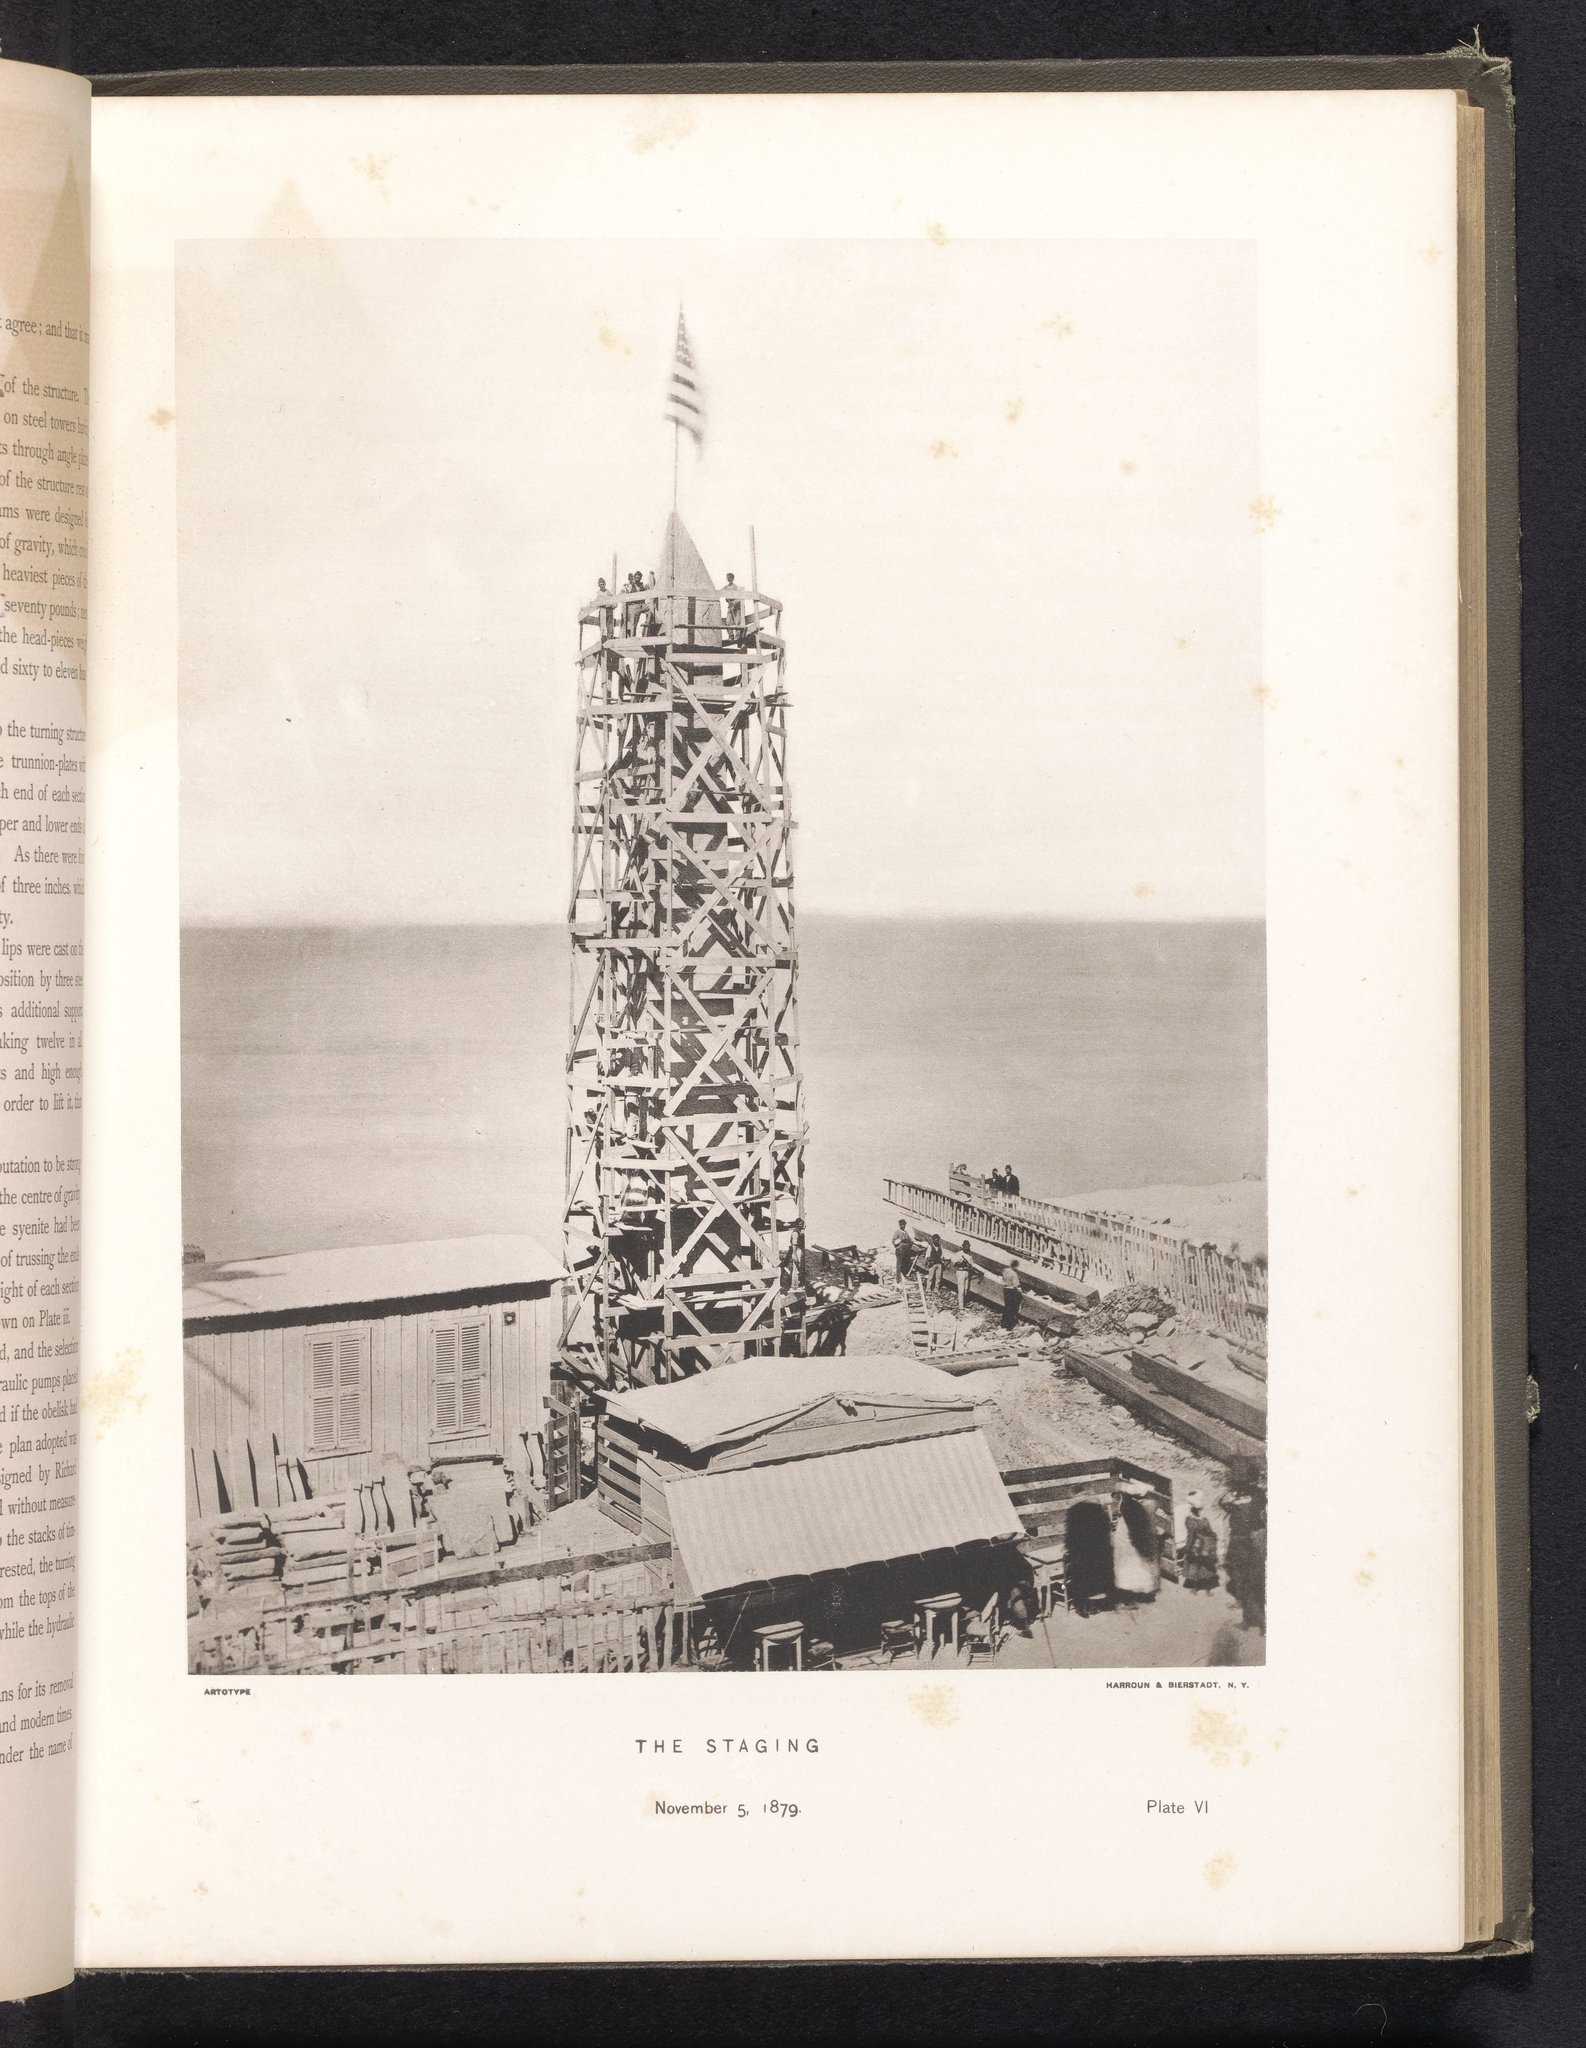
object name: photomechanical print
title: The staging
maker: Anonymous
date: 1879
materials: paper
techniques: photograph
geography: alexandria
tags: obelisk, needle, scaffold (~ building activities)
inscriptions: number: ‘Plate VI’